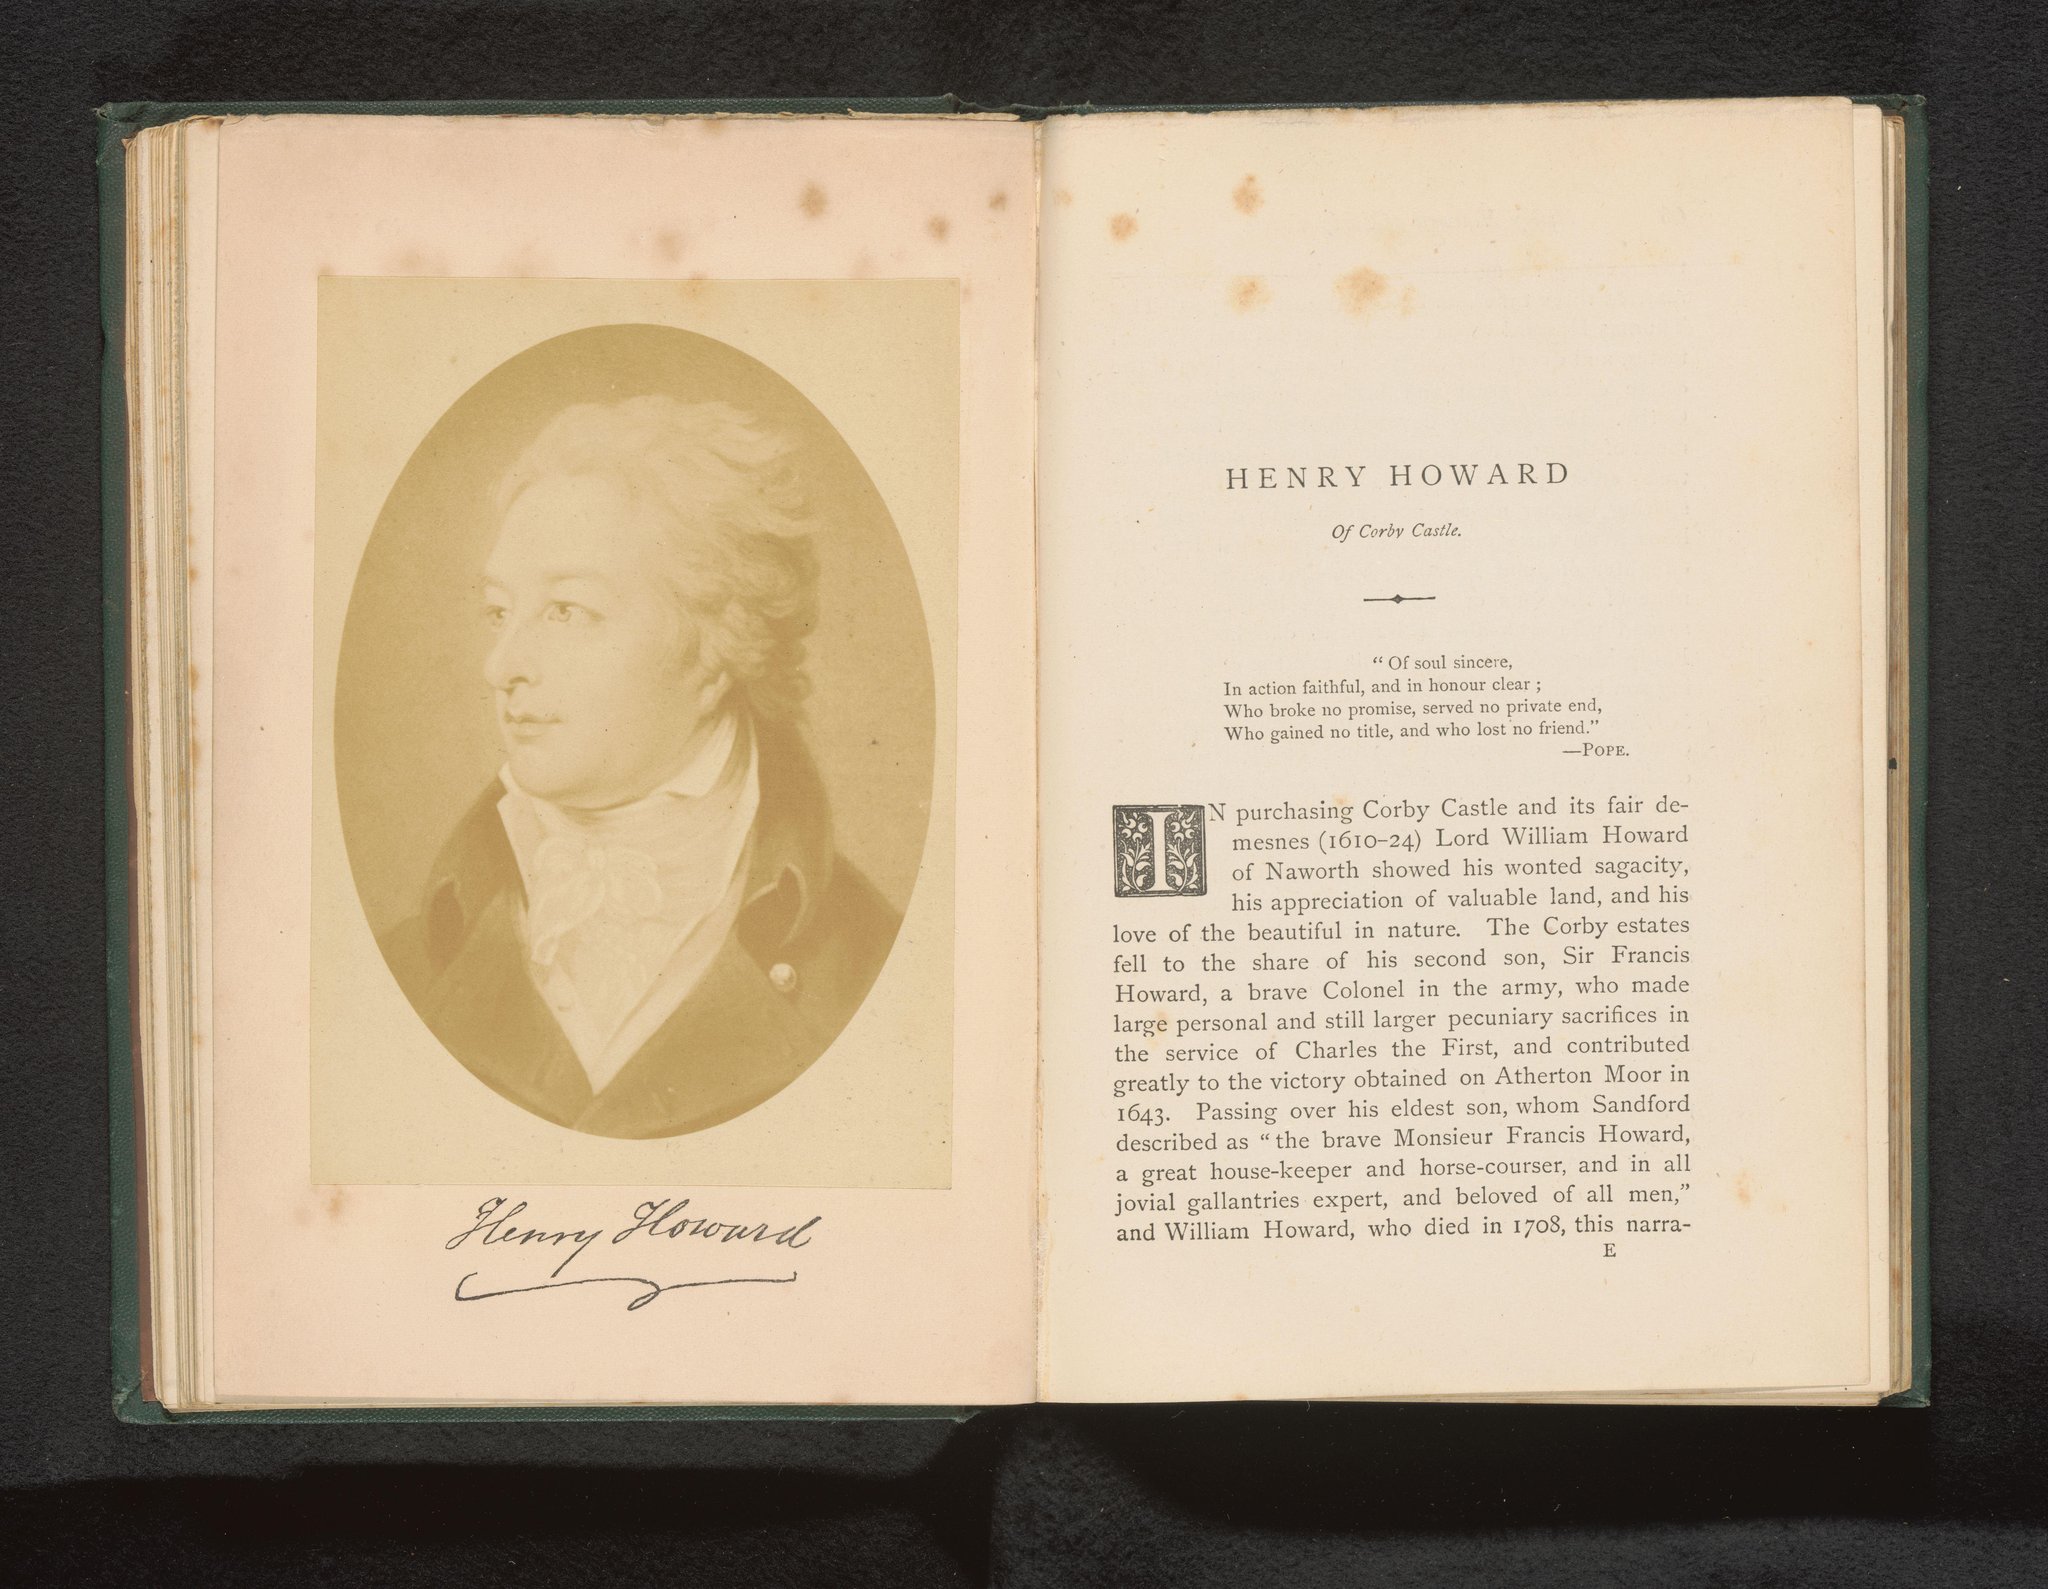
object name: photograph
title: Henry Howard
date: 1862-1872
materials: photographic support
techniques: albumen print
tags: print, e.g.: engraving, etching, lithograph, portrait of a writer